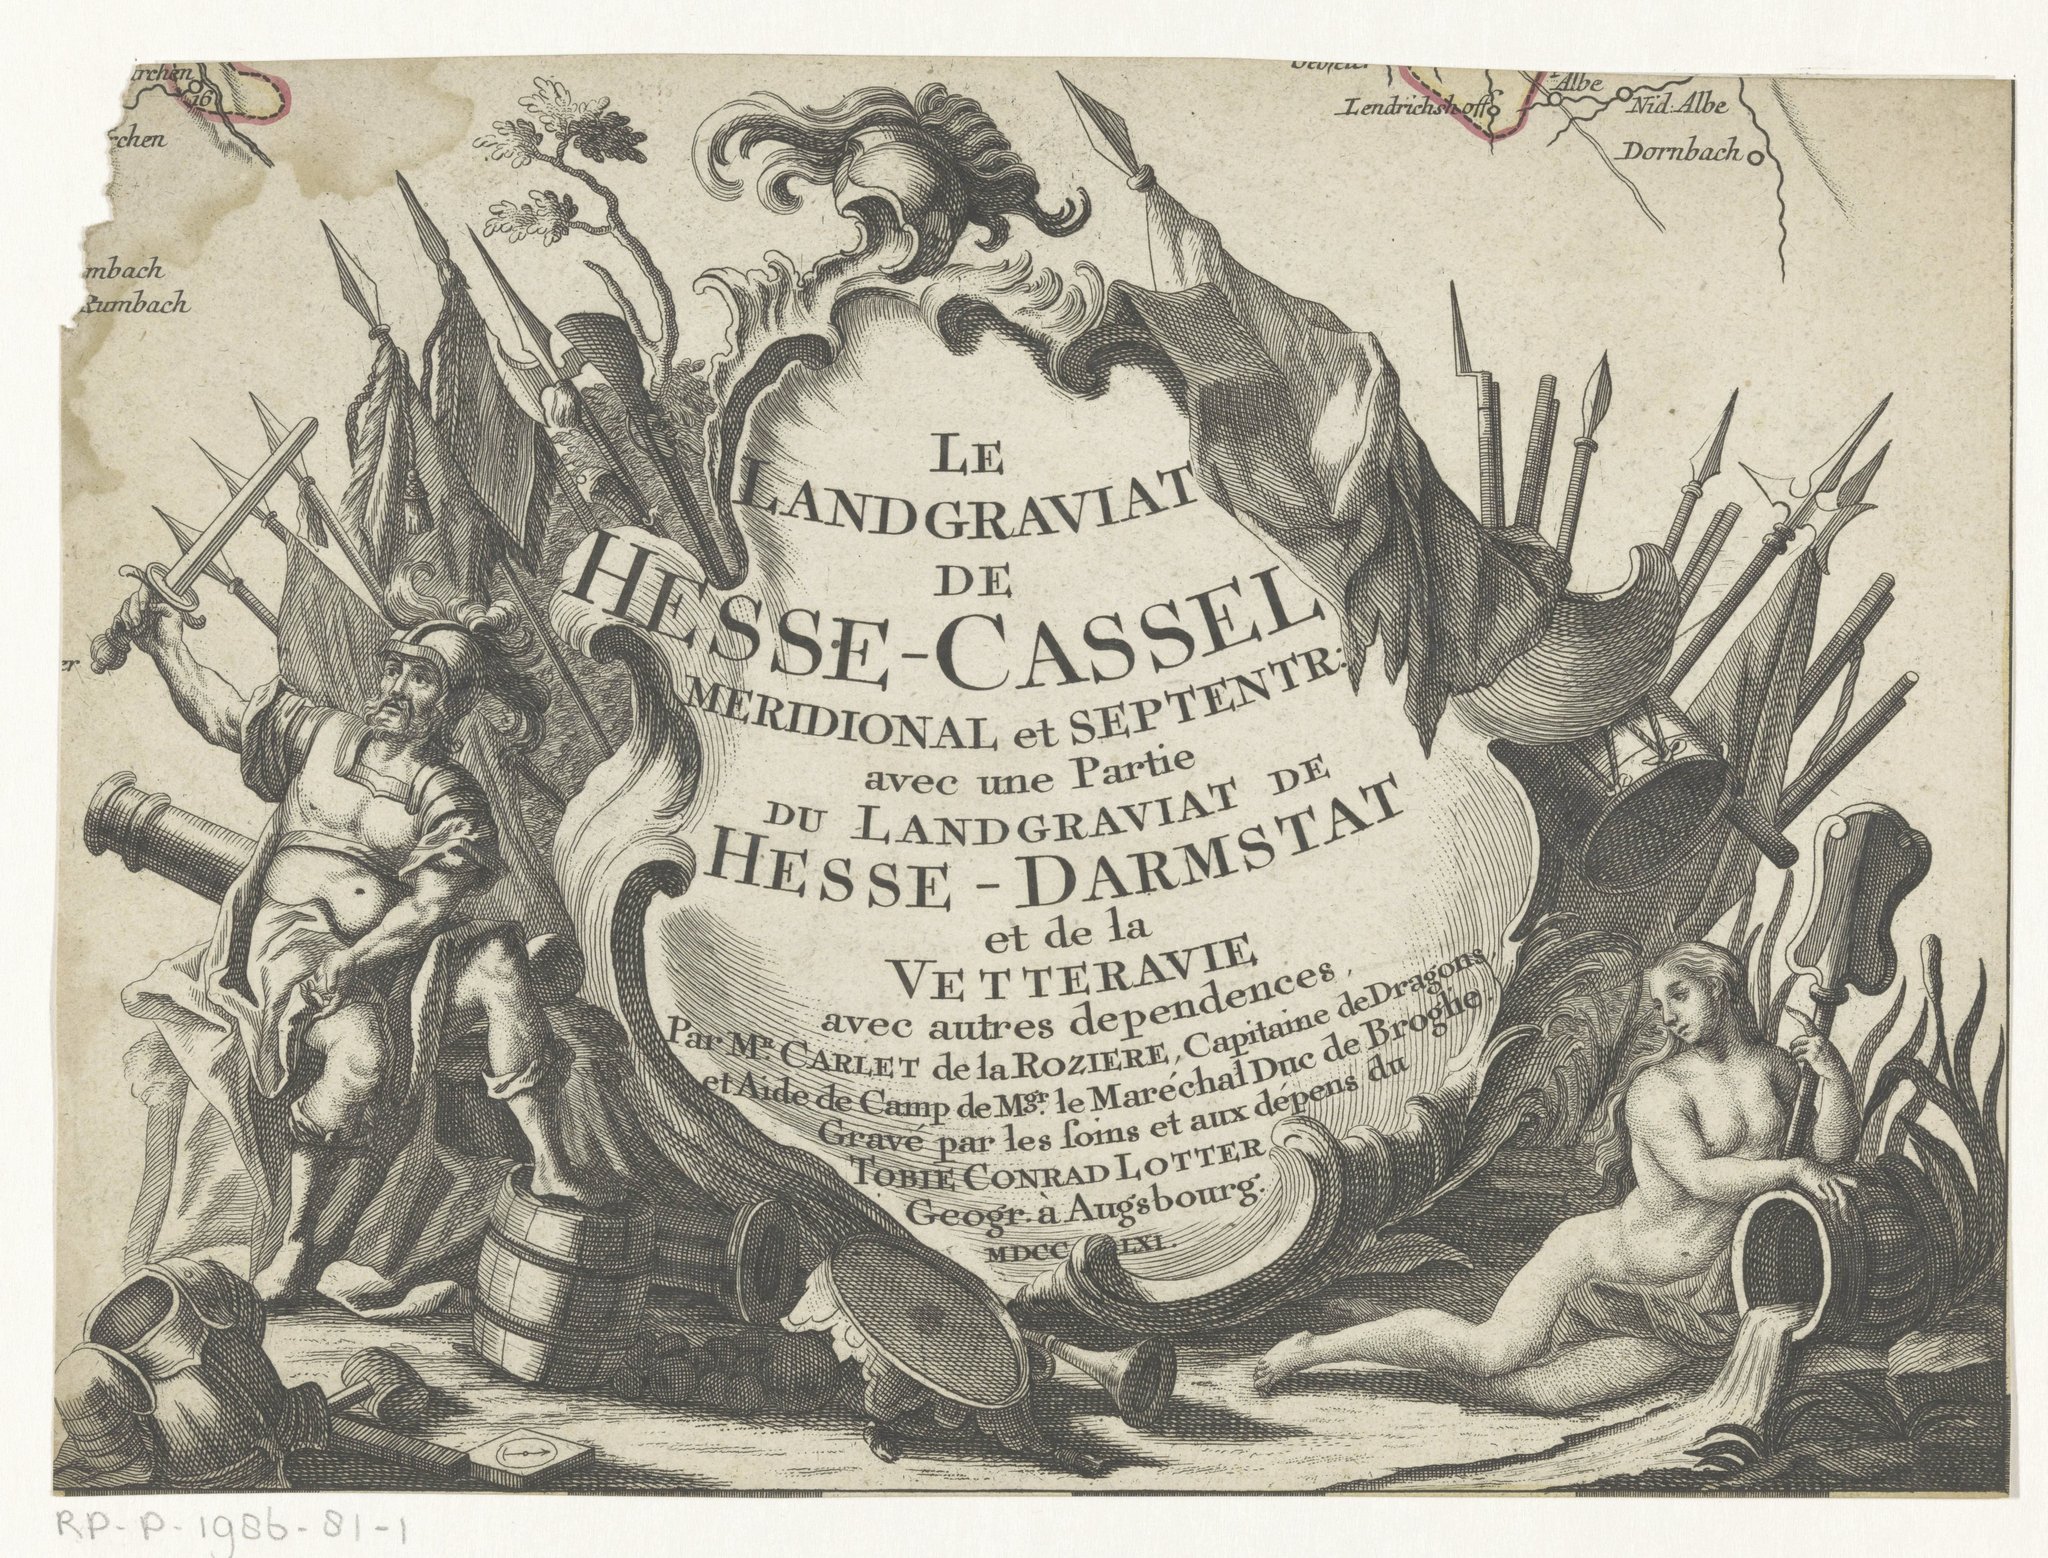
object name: print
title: Rocaille cartouche met man in harnas en riviergodin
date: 1761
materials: paper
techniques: engraving, etching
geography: augsburg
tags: river-gods, weapons, ornament ~ cartouche, the soldier; the soldier's life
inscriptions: collector's mark: Lugt 2228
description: Rocaille cartouche met titel omringd door wapens en lansen. Links staat een man in harnas met zwaard, rechts zit een riviergodin. Detail van een kaart van de landgraafschappen Hessen-Kassel ten Hessen-Darmstadt te Duitsland.